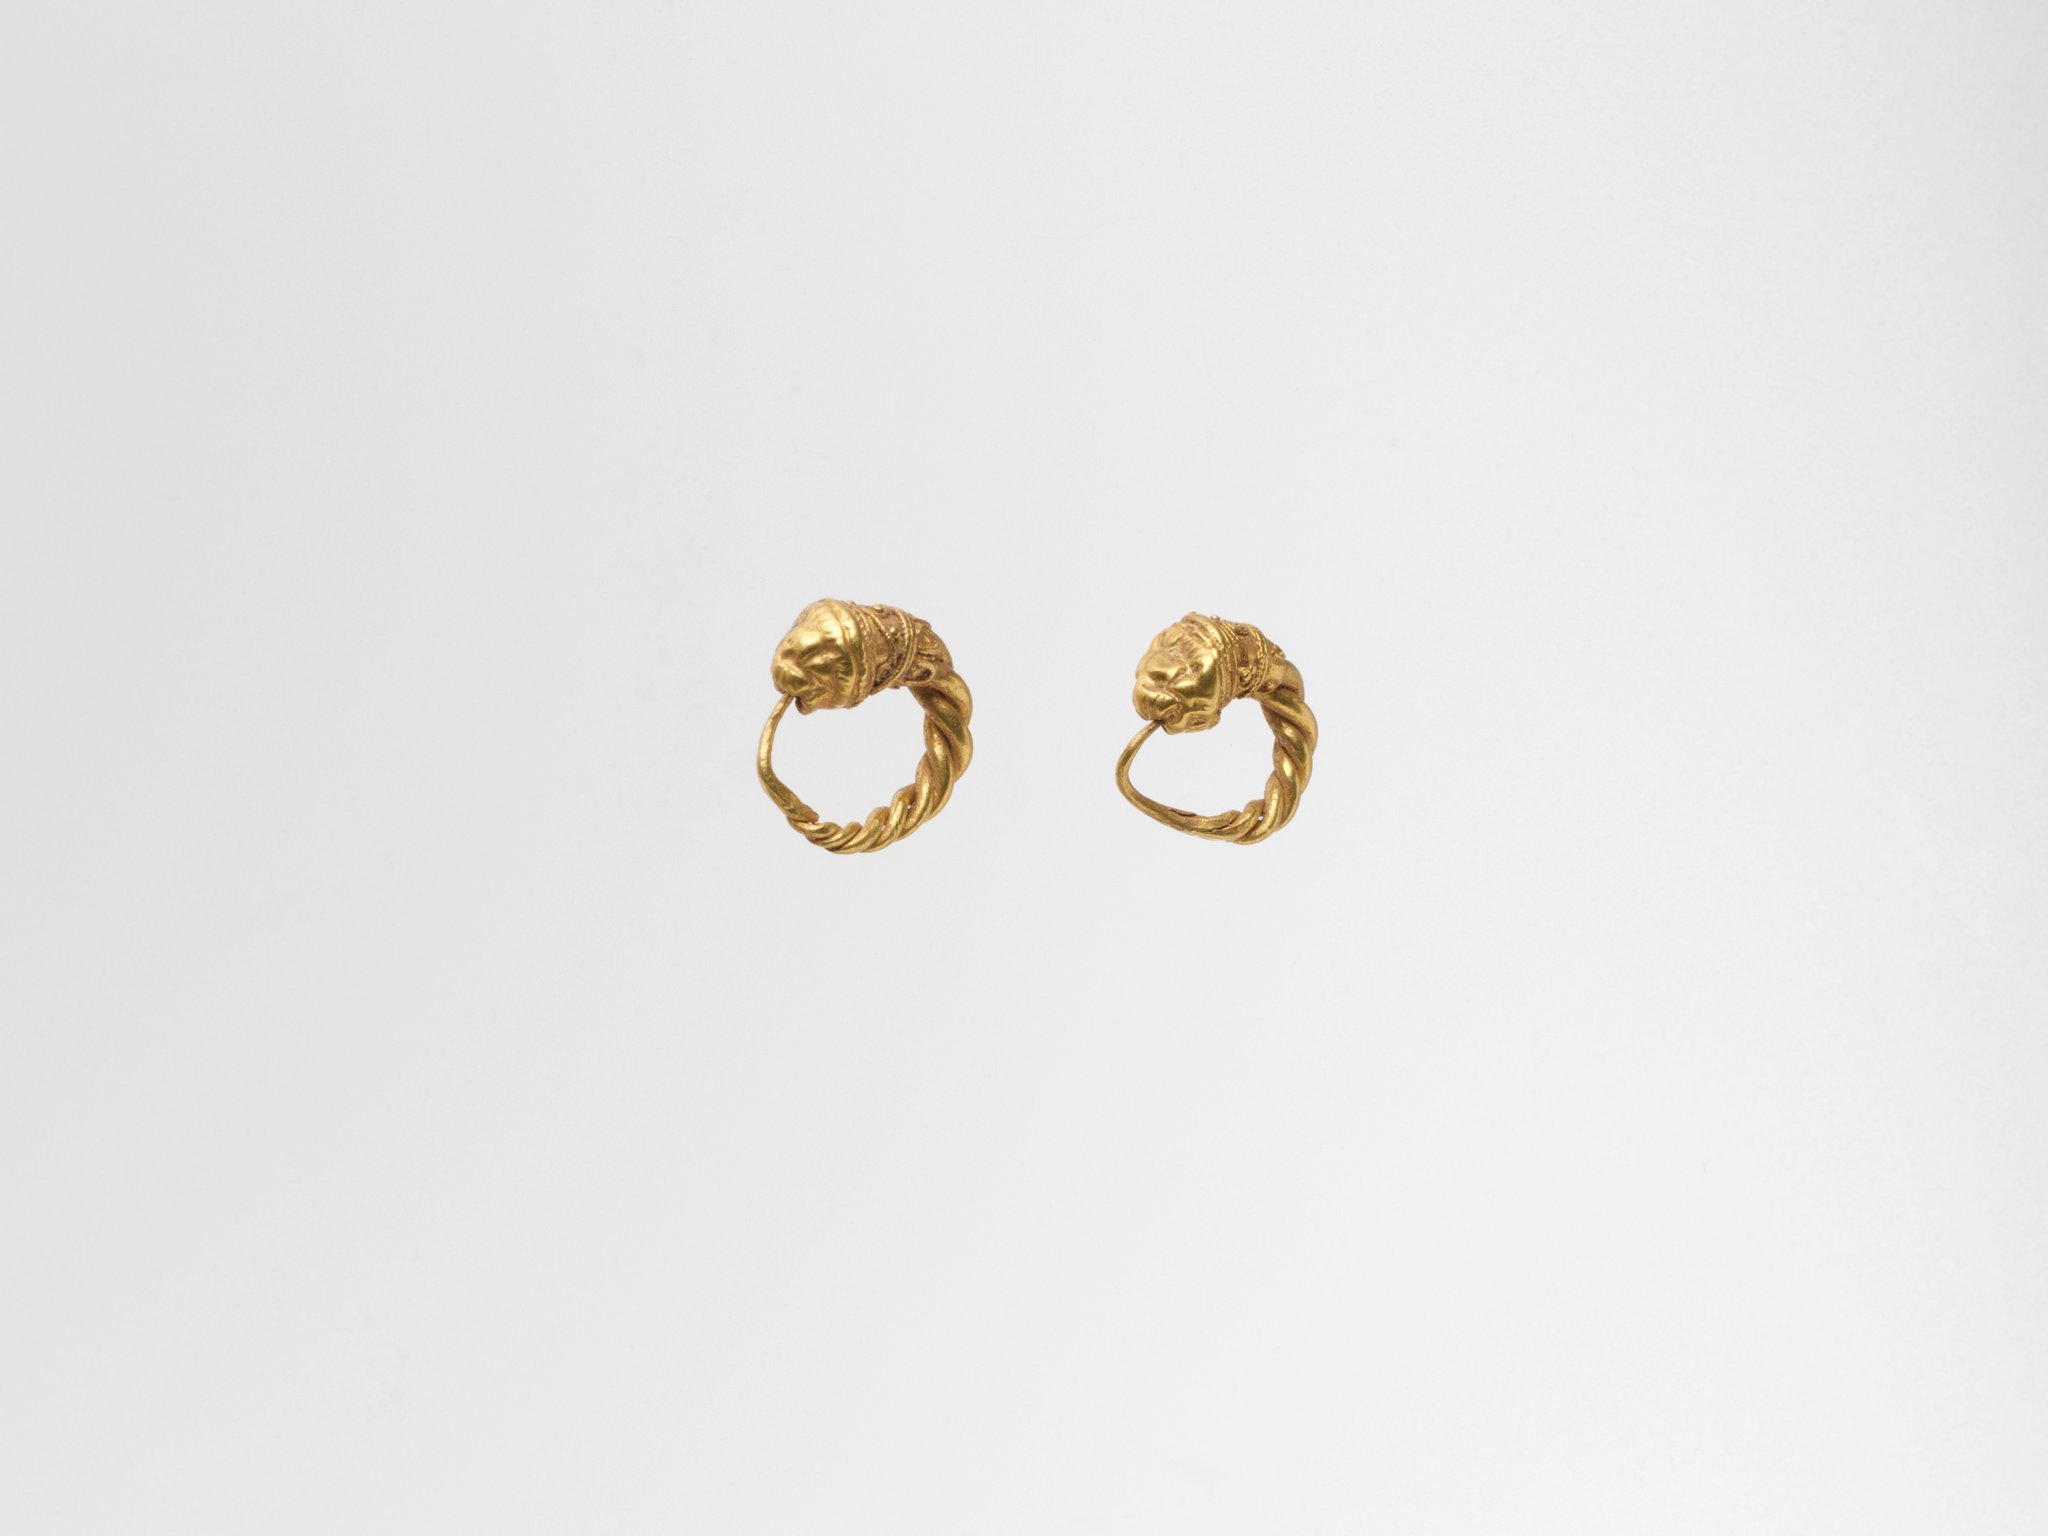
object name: earring with head of lion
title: Gold earring with head of a lion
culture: greek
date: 400-201 BCE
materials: gold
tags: lions